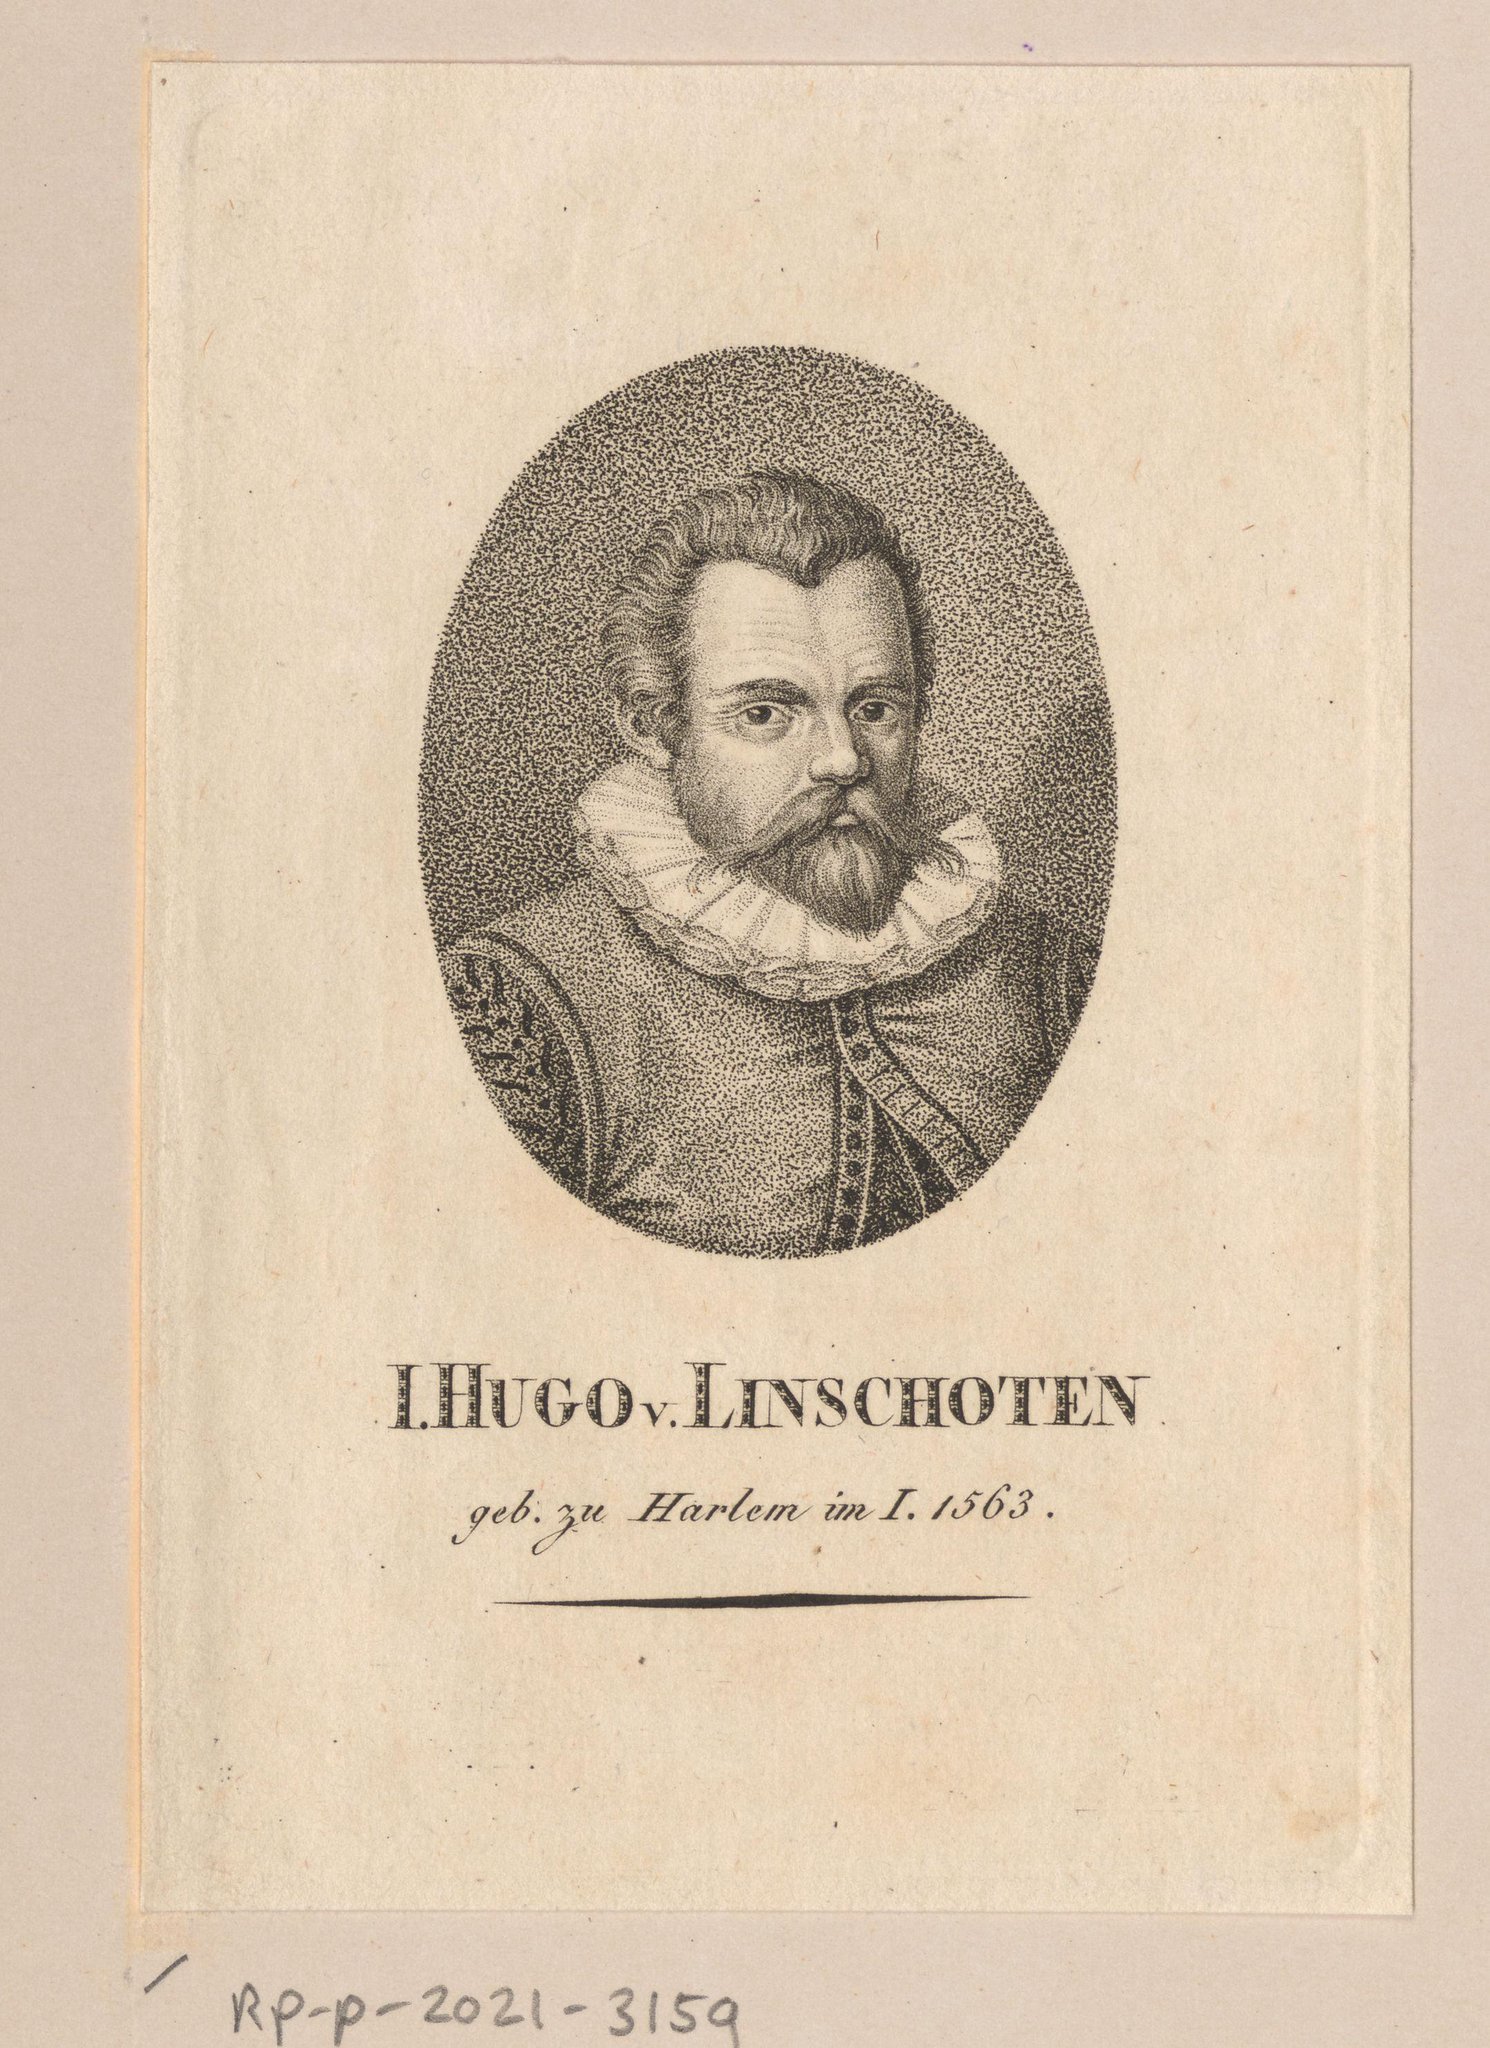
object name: print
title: Portret van Jan Huygen van Linschoten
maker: konrad westermayr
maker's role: print maker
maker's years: 1765-1834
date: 1775-1834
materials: paper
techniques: stippling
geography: germany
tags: haarlem, jan huygen van linschoten, historical persons, portrait of a writer, wandering or travelling merchant